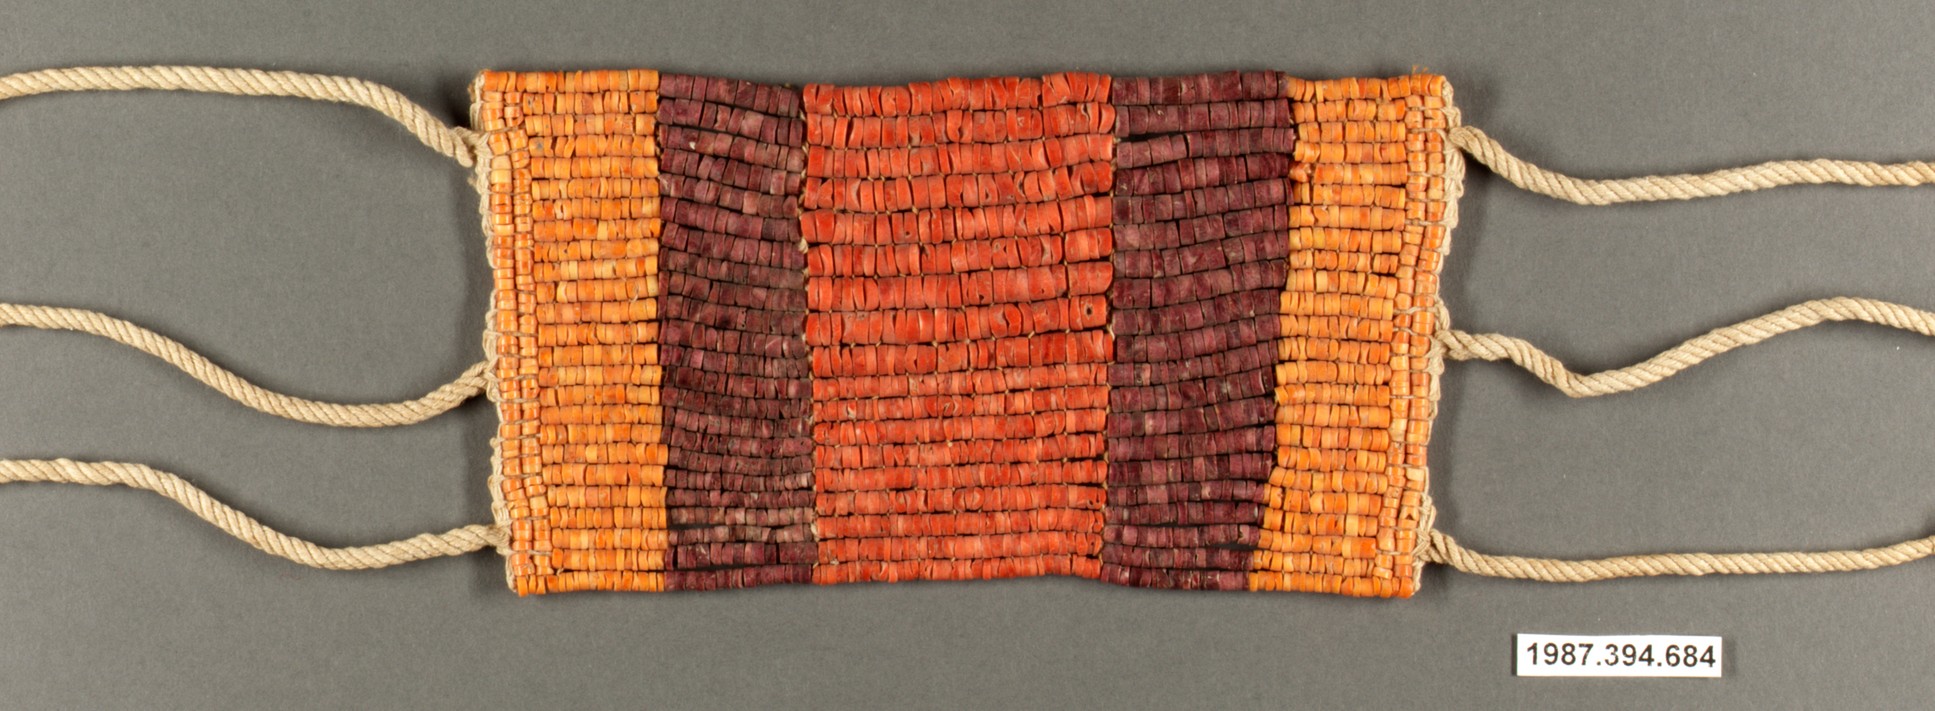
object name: bracelet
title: Beaded Wrist Ornament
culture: chancay or chimú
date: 1301-1500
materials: cotton, shell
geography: peru